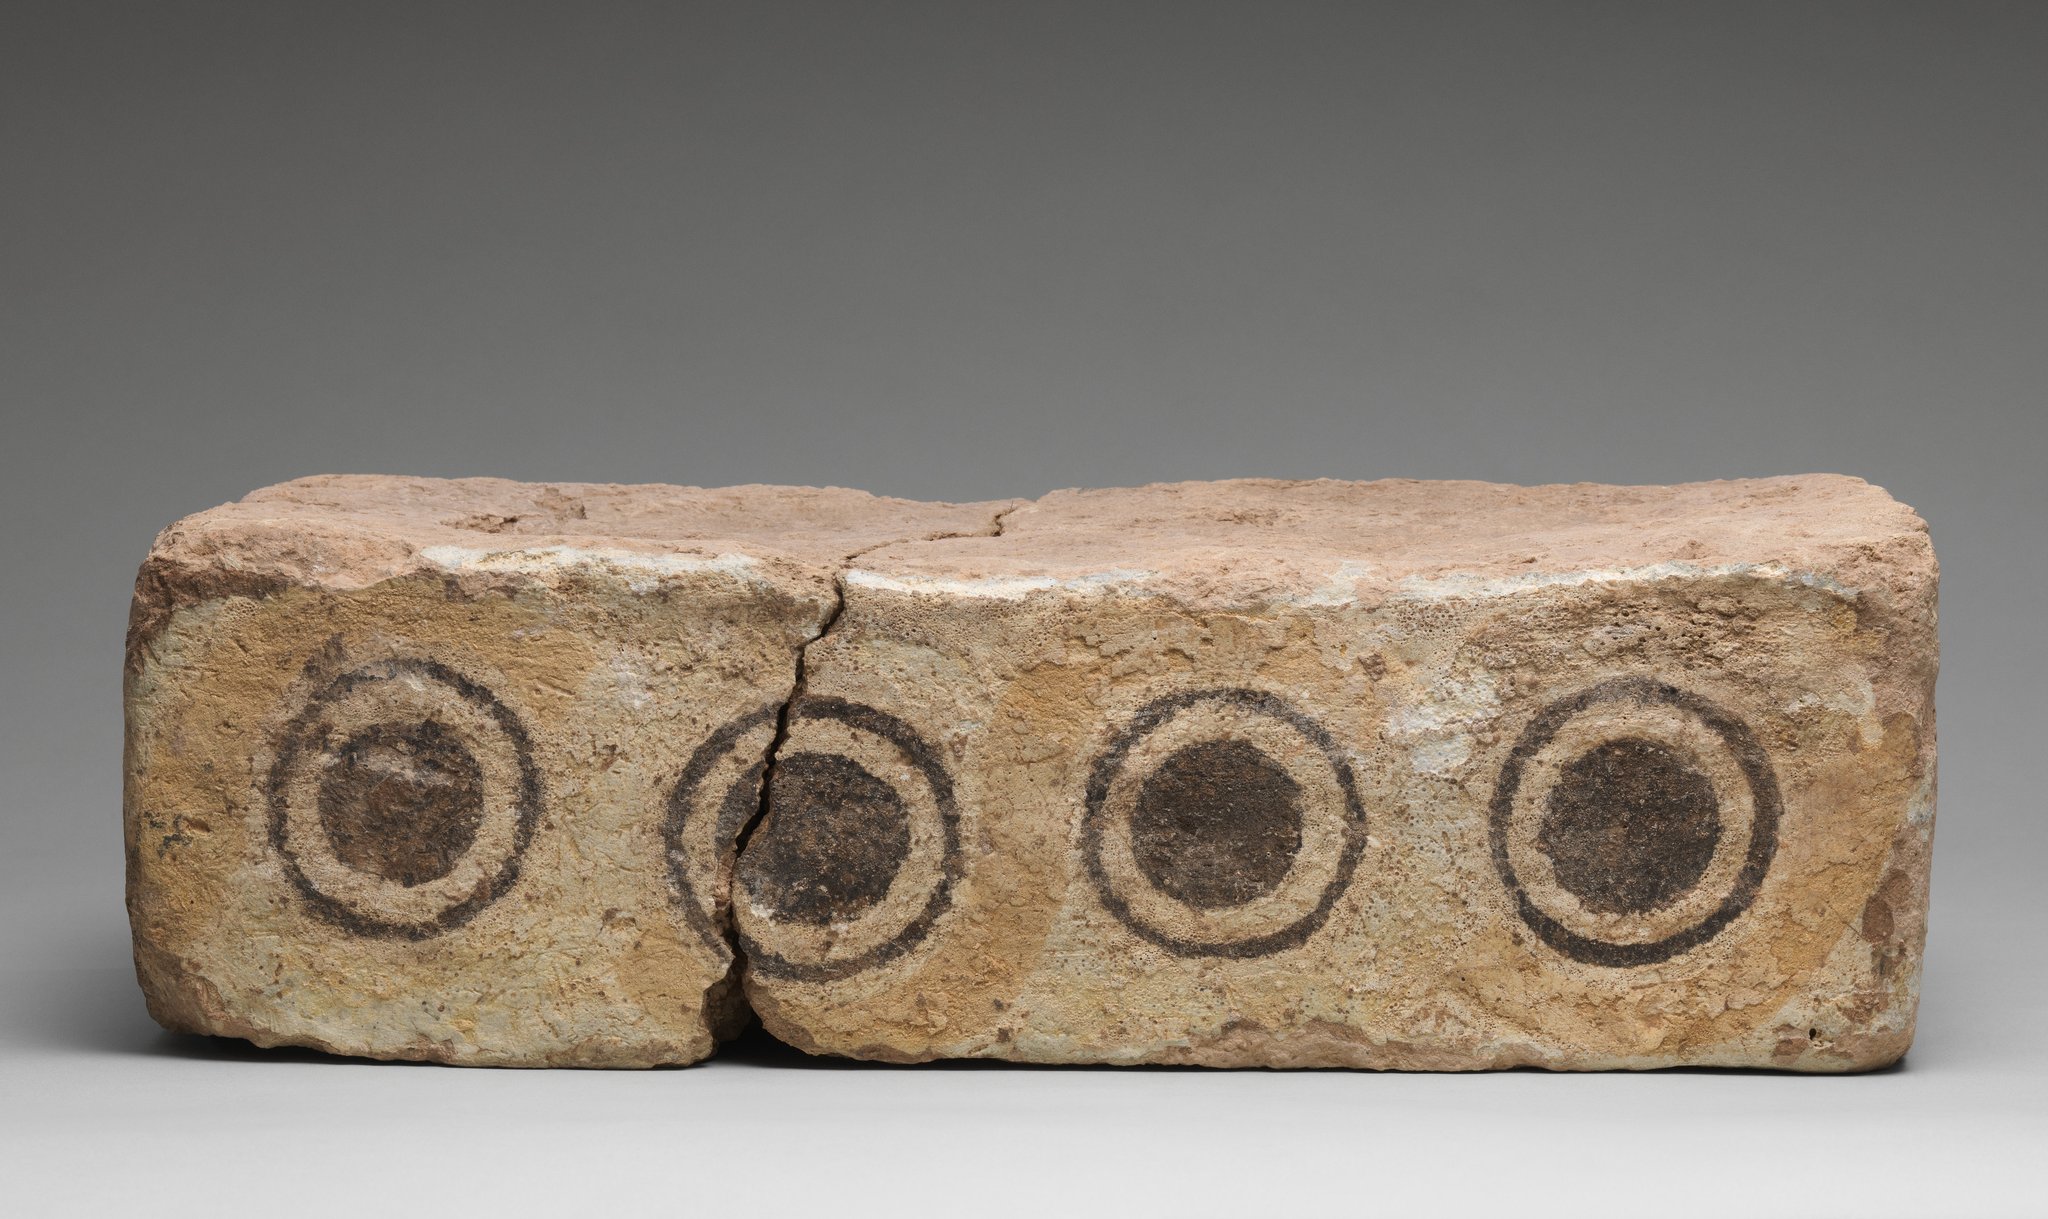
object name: brick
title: Brick with guilloche design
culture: assyrian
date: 900-801 BCE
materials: ceramic, glaze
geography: mesopotamia